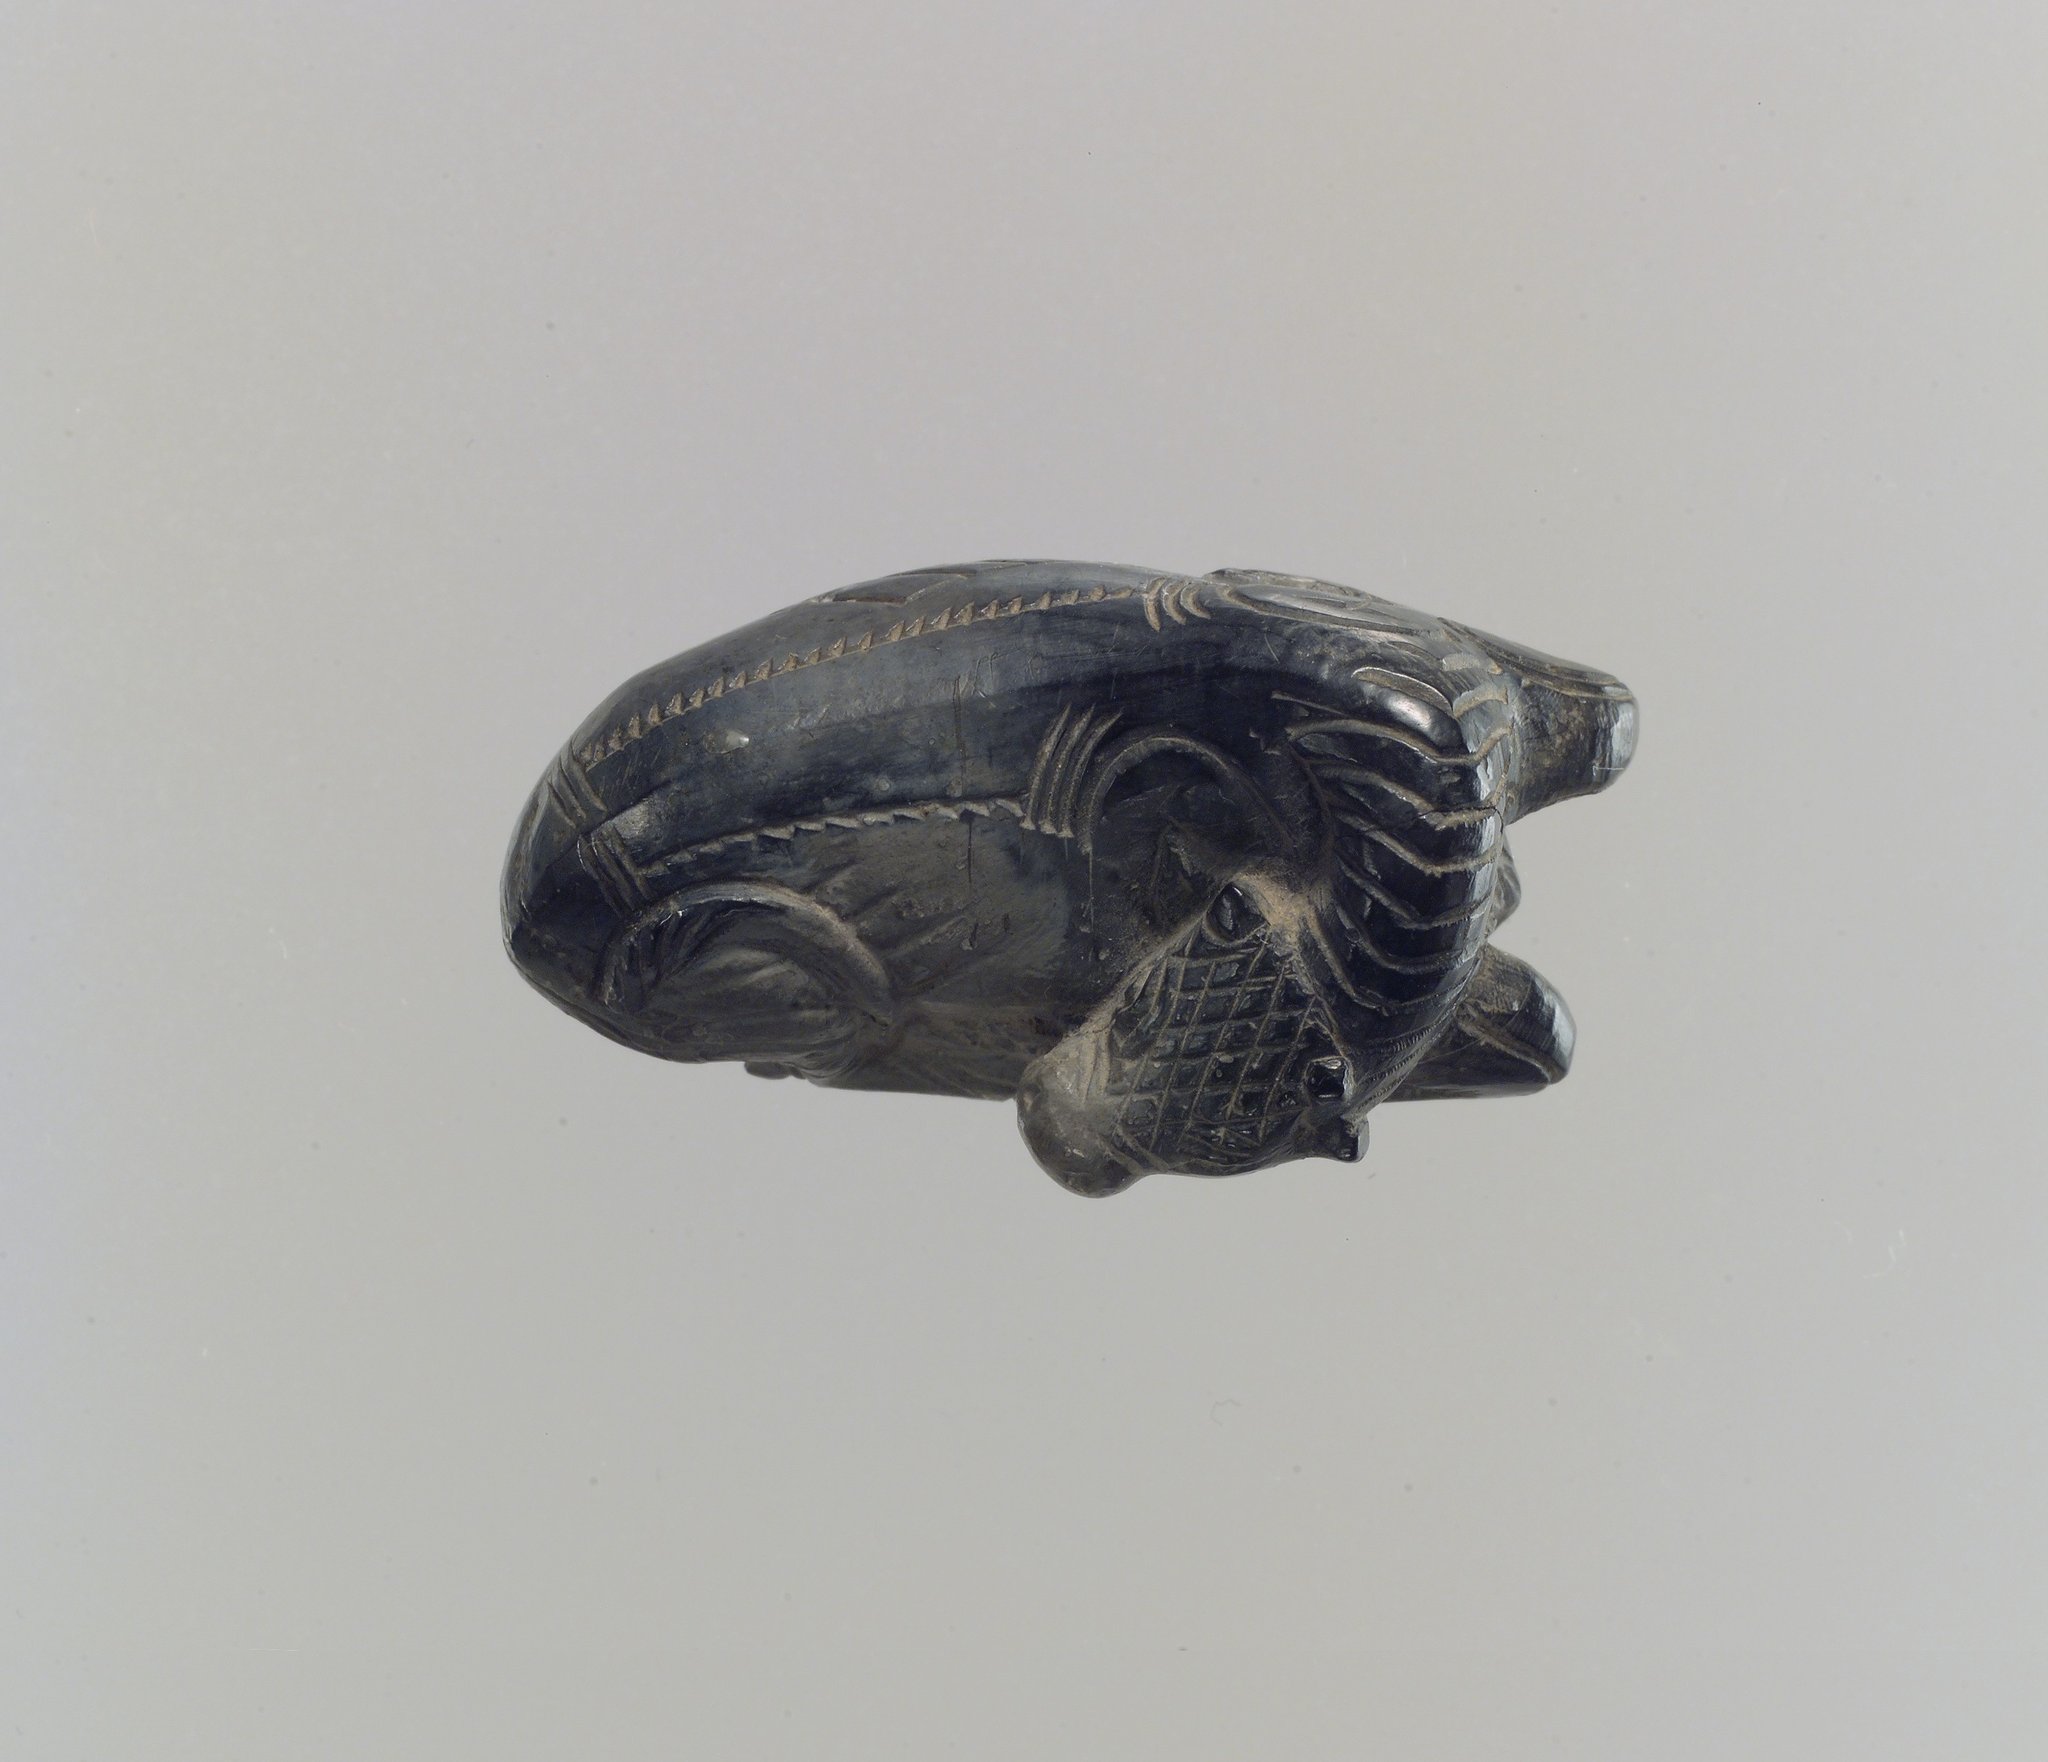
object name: lid attachment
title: Reclining calf: lid attachment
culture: assyrian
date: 900-701 BCE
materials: ivory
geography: mesopotamia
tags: animals